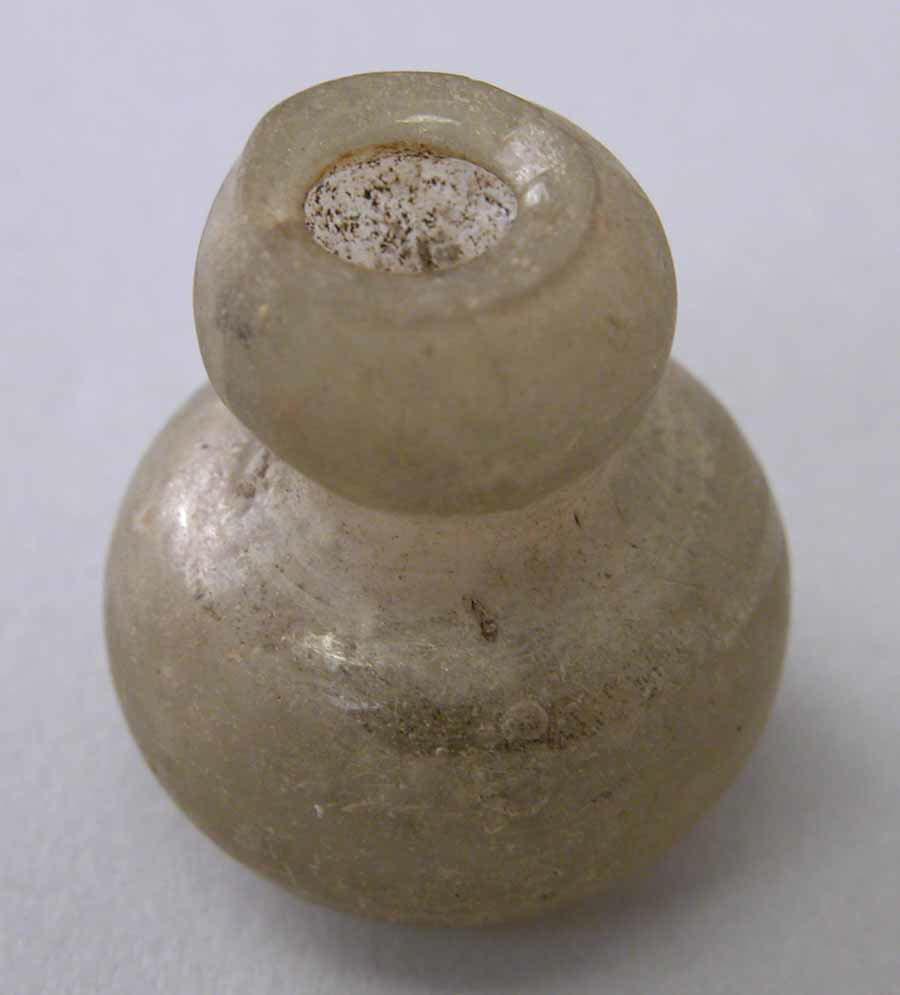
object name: bottle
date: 801-1100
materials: glass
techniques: glassblowing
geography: egypt